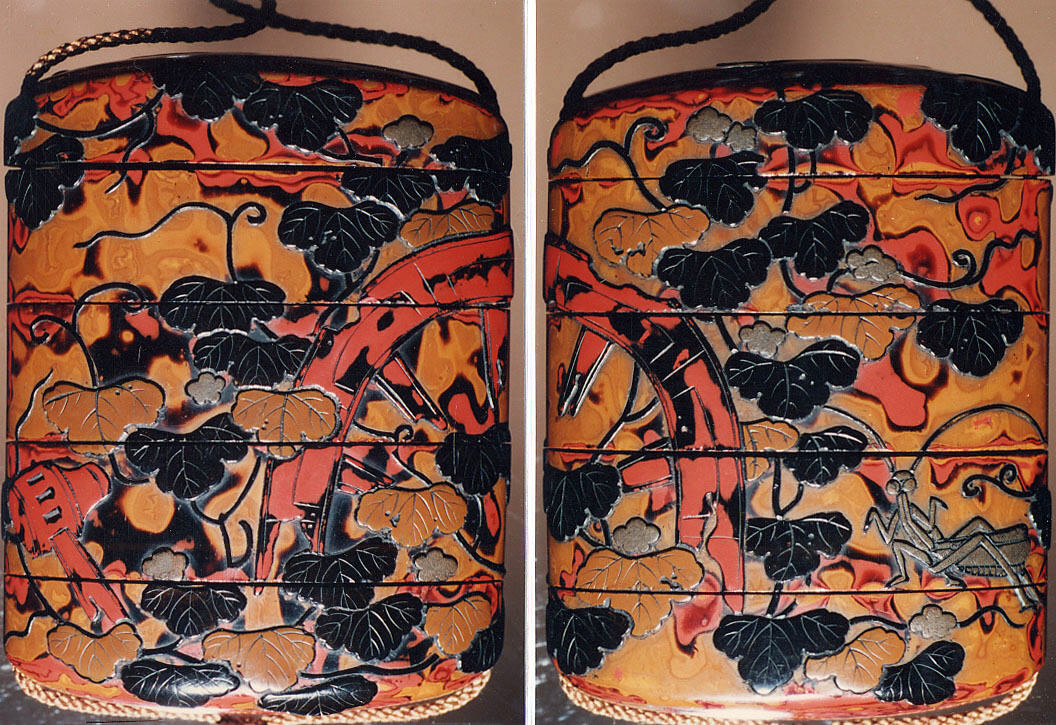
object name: inrō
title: Case (Inrō) with Design of Praying Mantis beside Broken Wheel Overgrown with Vines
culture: japanese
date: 1801-1900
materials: lacquer, marble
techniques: roiro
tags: insects,vines